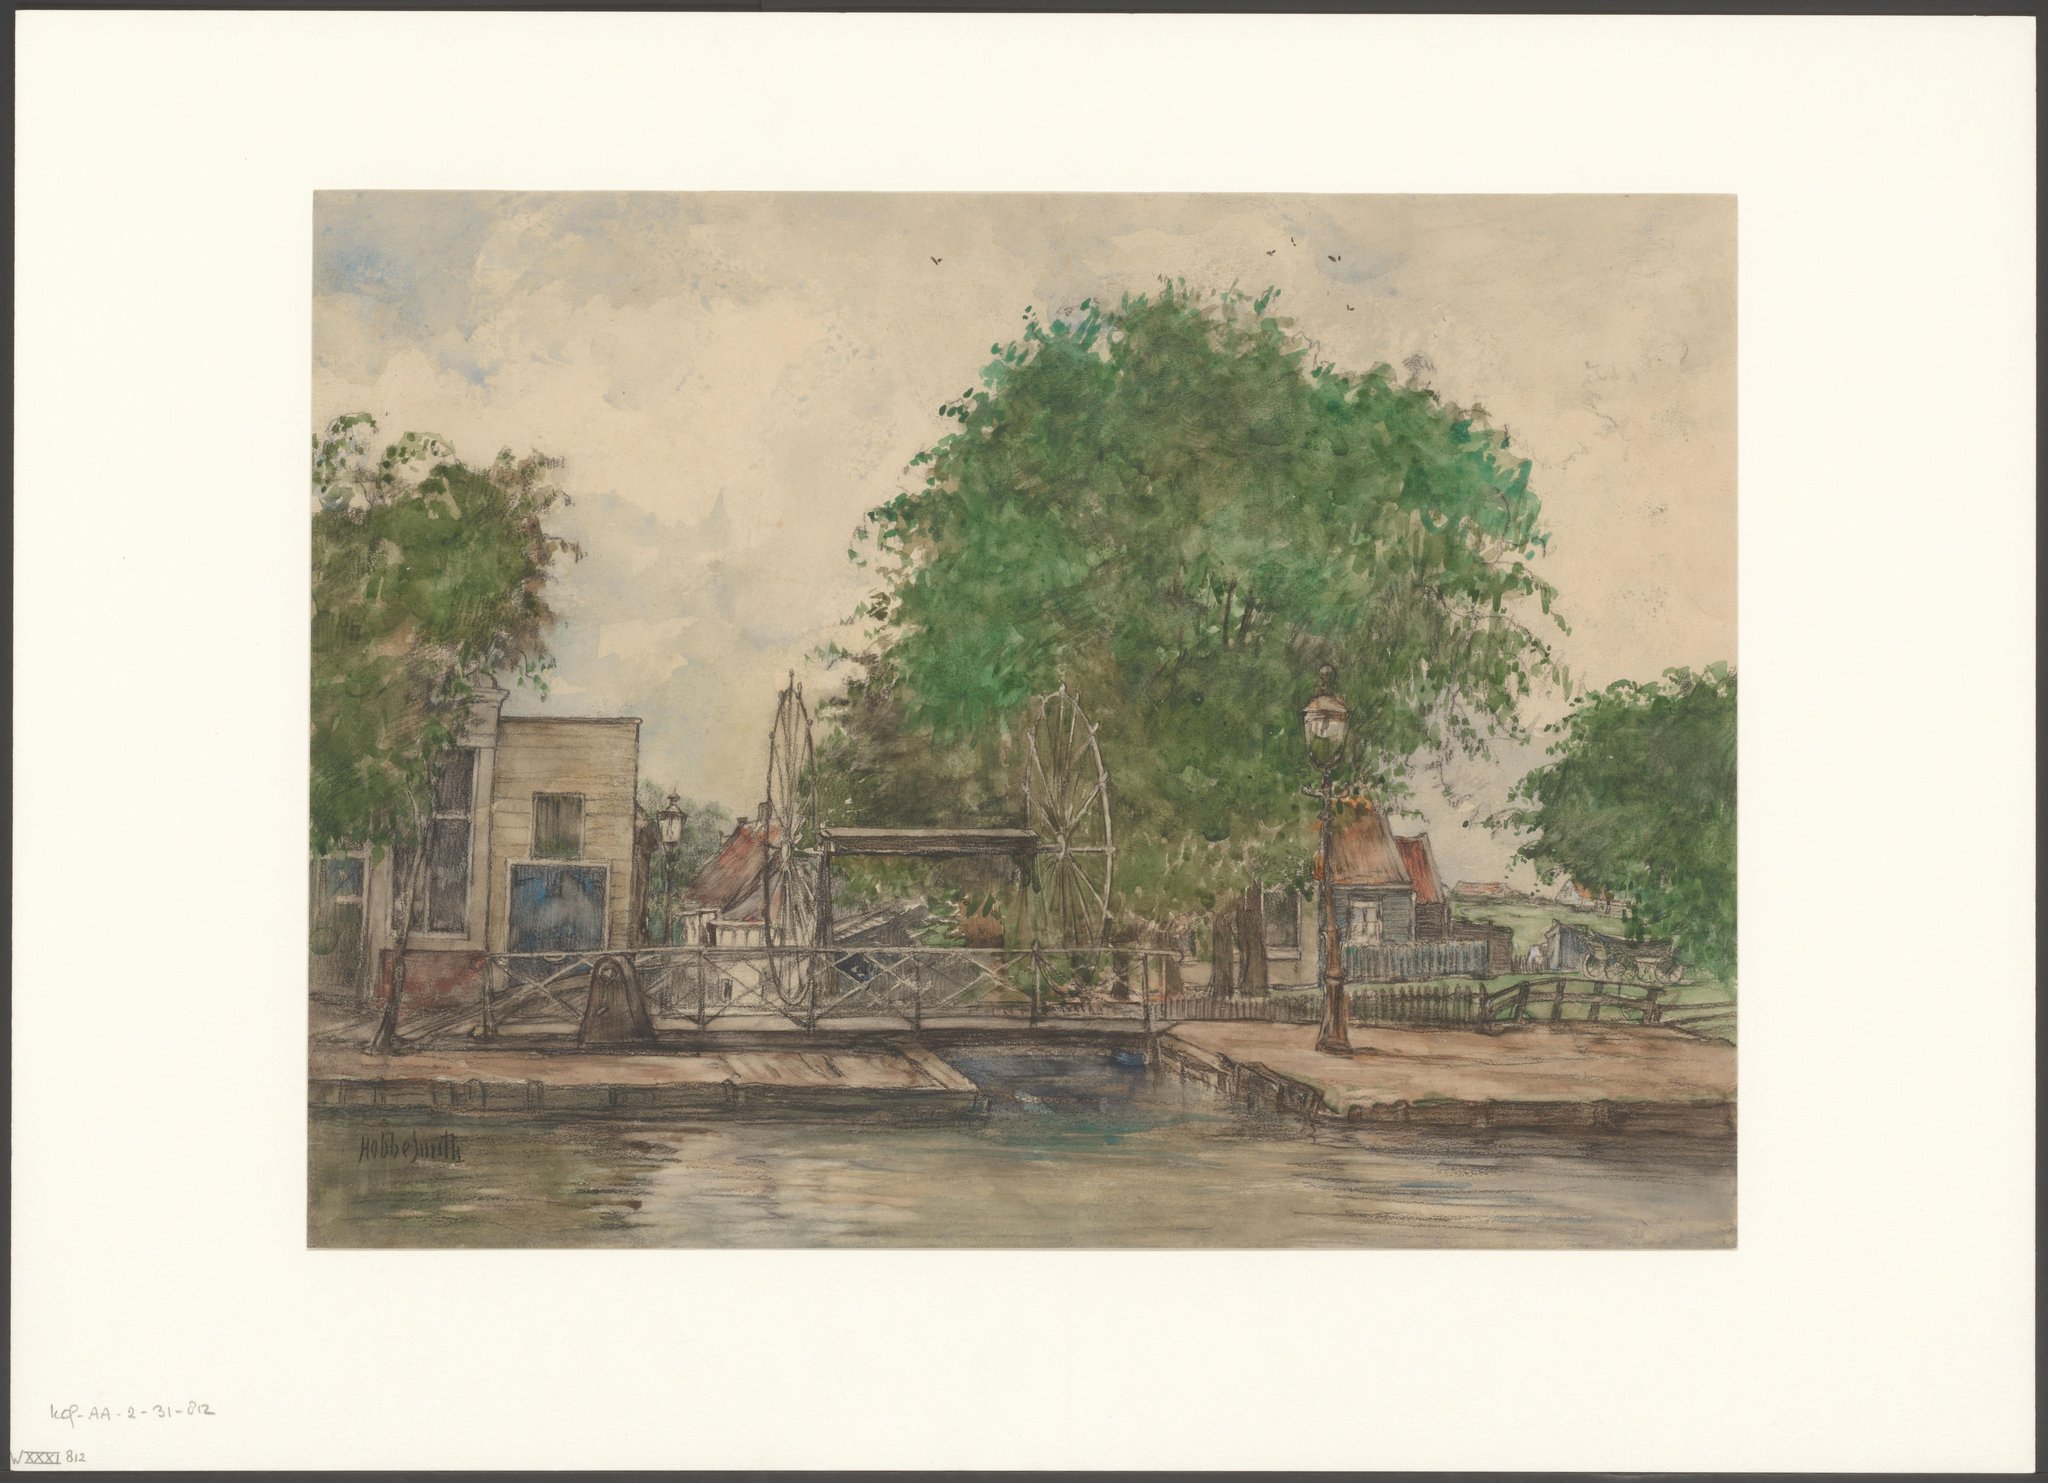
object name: drawing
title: Gezicht op een overtoom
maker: hobbe smith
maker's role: painter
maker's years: 1862-1942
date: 1872-1942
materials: chalk, gouache, paper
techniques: brush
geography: amsterdam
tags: city-view in general; 'veduta', canal, lift-lock, canal lock, amsterdam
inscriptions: signature: ‘HobbeSmith’, collector's mark: Lugt 800a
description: Tekening binnen de Atlas Van Eck ingedeeld op wijknummer 31.